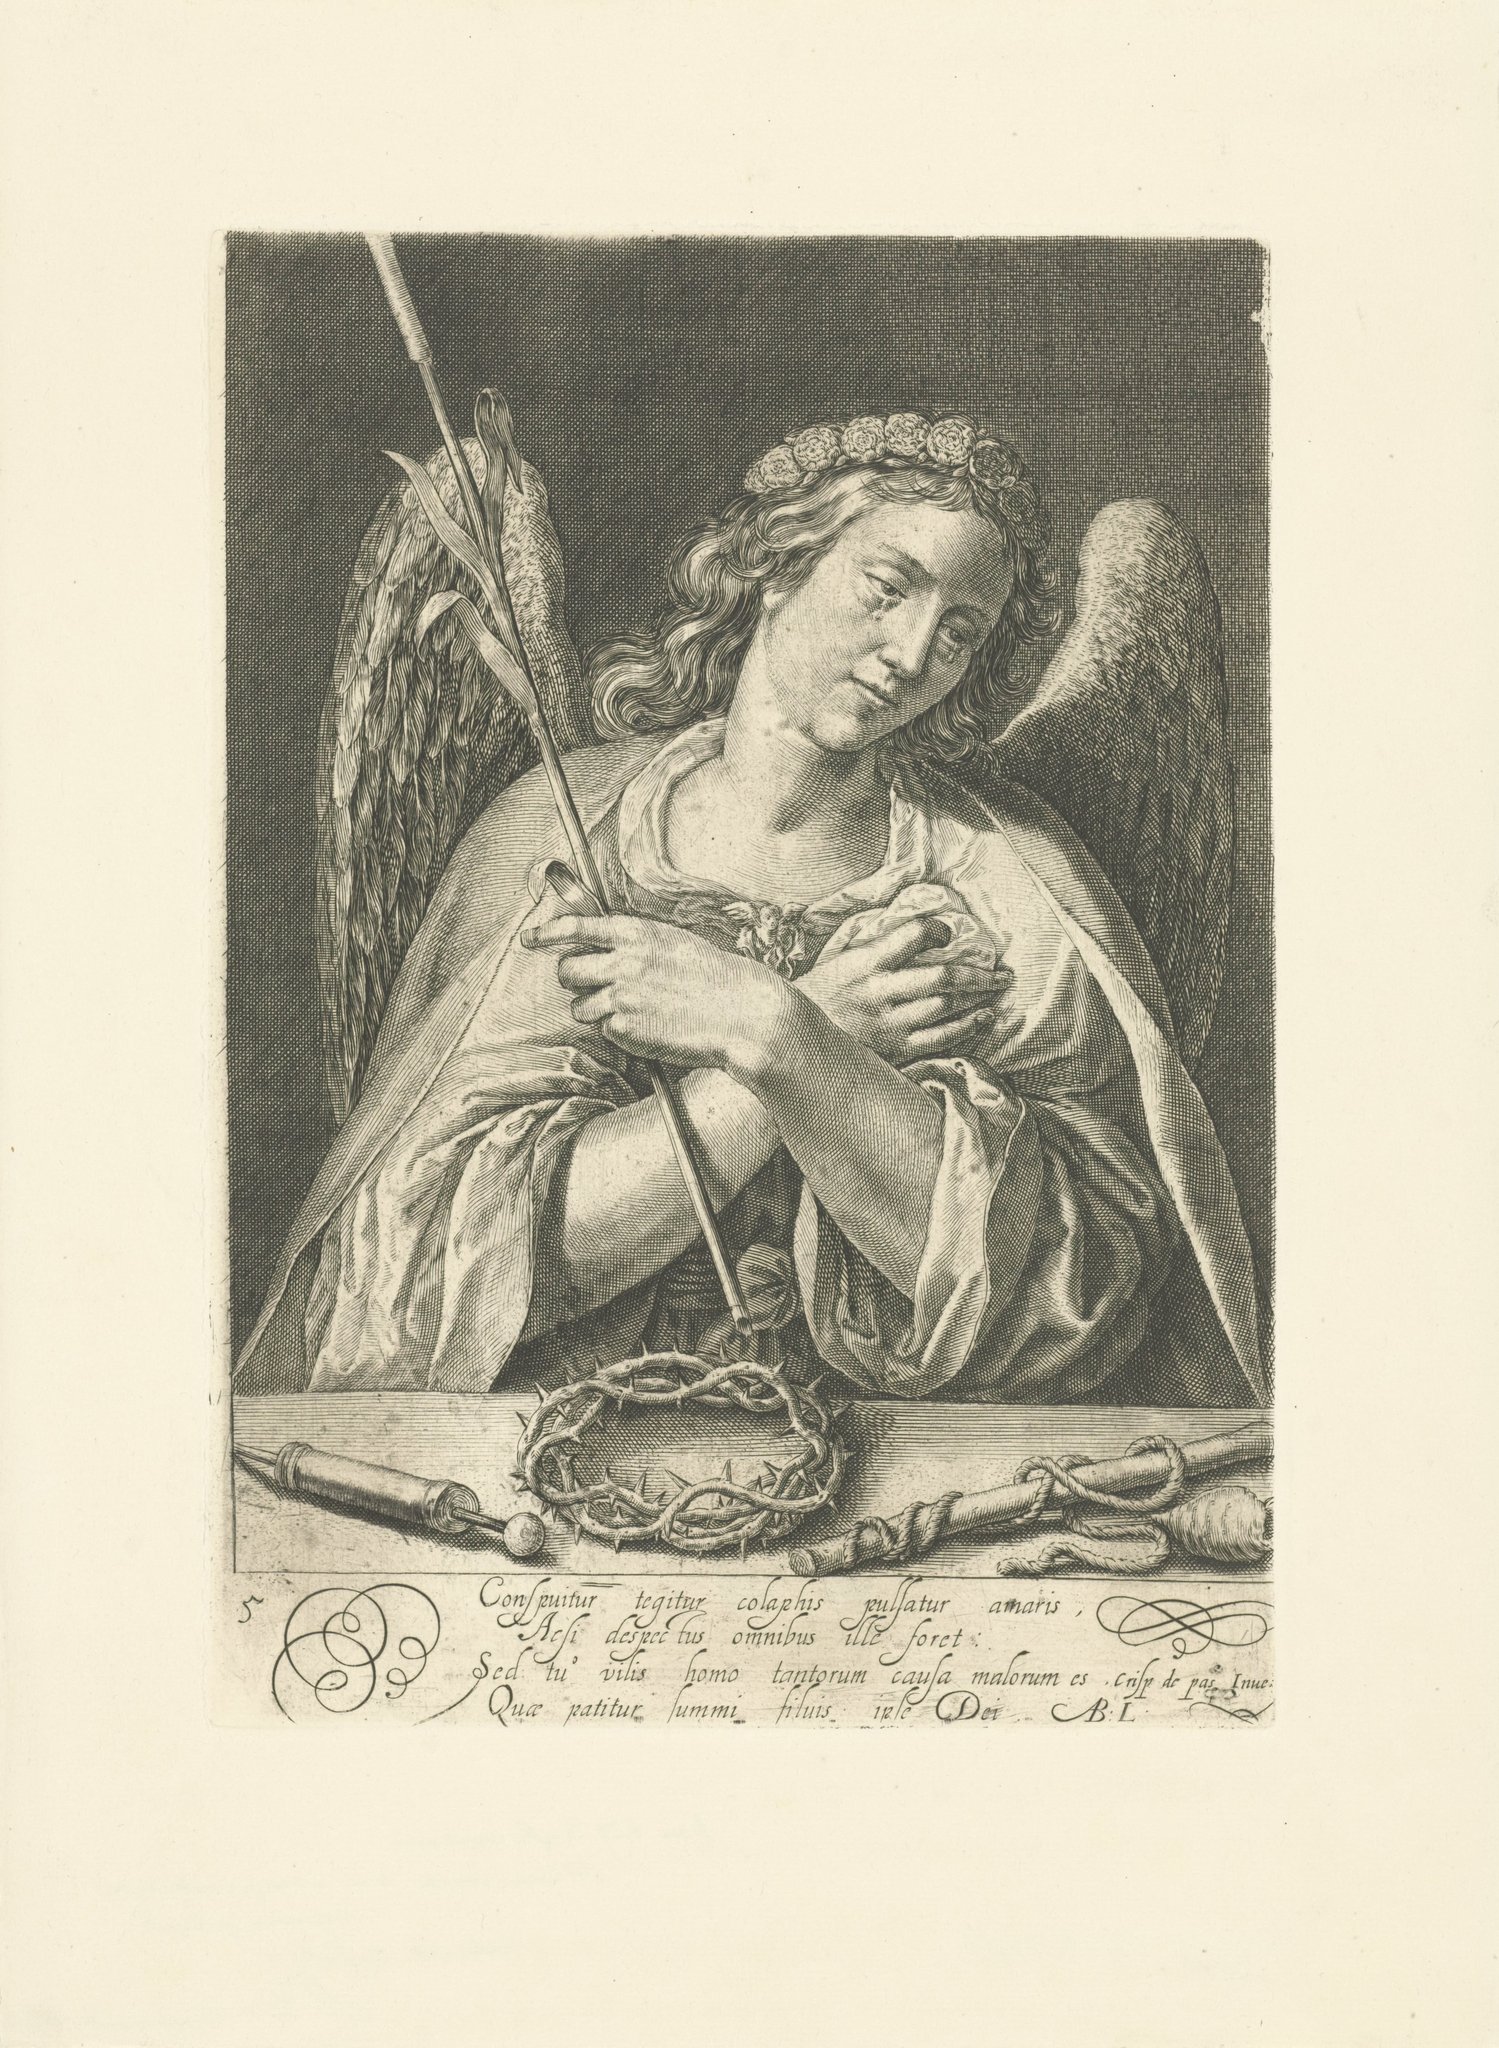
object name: print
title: Huilende engel met passiewerktuigen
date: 1574-1637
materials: paper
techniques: engraving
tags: single instruments of the passion, weeping, angels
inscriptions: collector's mark: Lugt 2228, inscription: ‘Aan het Rijksmuseum [...] Conservator ABM.’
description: Buste van een huilende engel, met rietstok in de hand, gekroond met een rozenkrans. Op de balustrade voor hem liggen andere passiewerktuigen. Linksonder genummerd: 5. In de marge een vierregelig onderschrift in het Latijn.